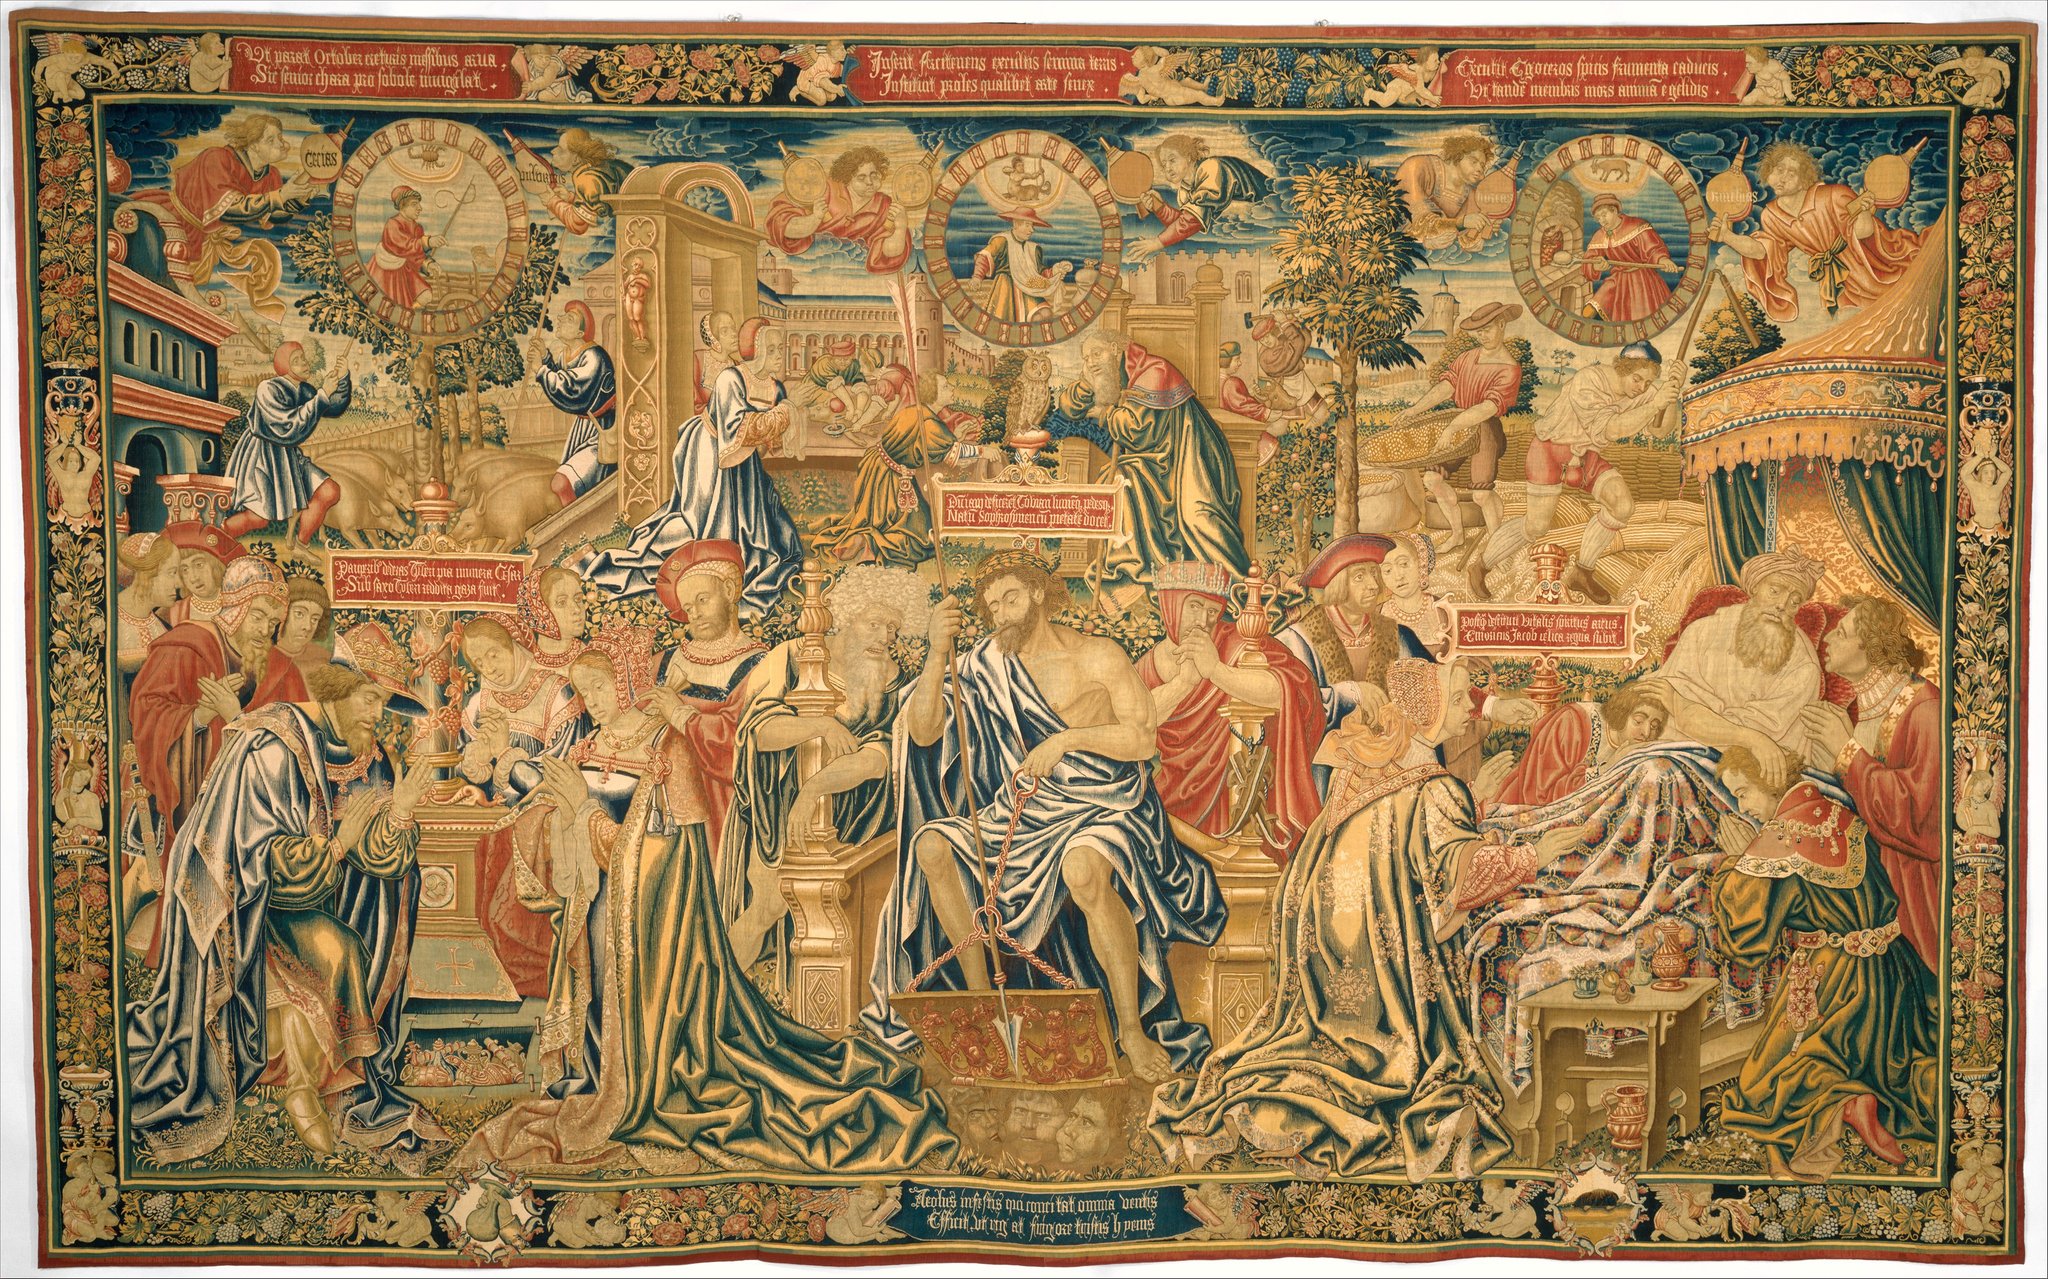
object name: tapestry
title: The Twelve Ages of a Man: The Last Three Ages (54-72), or Winter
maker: bernard van orley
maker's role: designer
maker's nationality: netherlandish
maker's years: 1492-1542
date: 1515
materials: silk, wool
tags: men,women,plants,zodiac